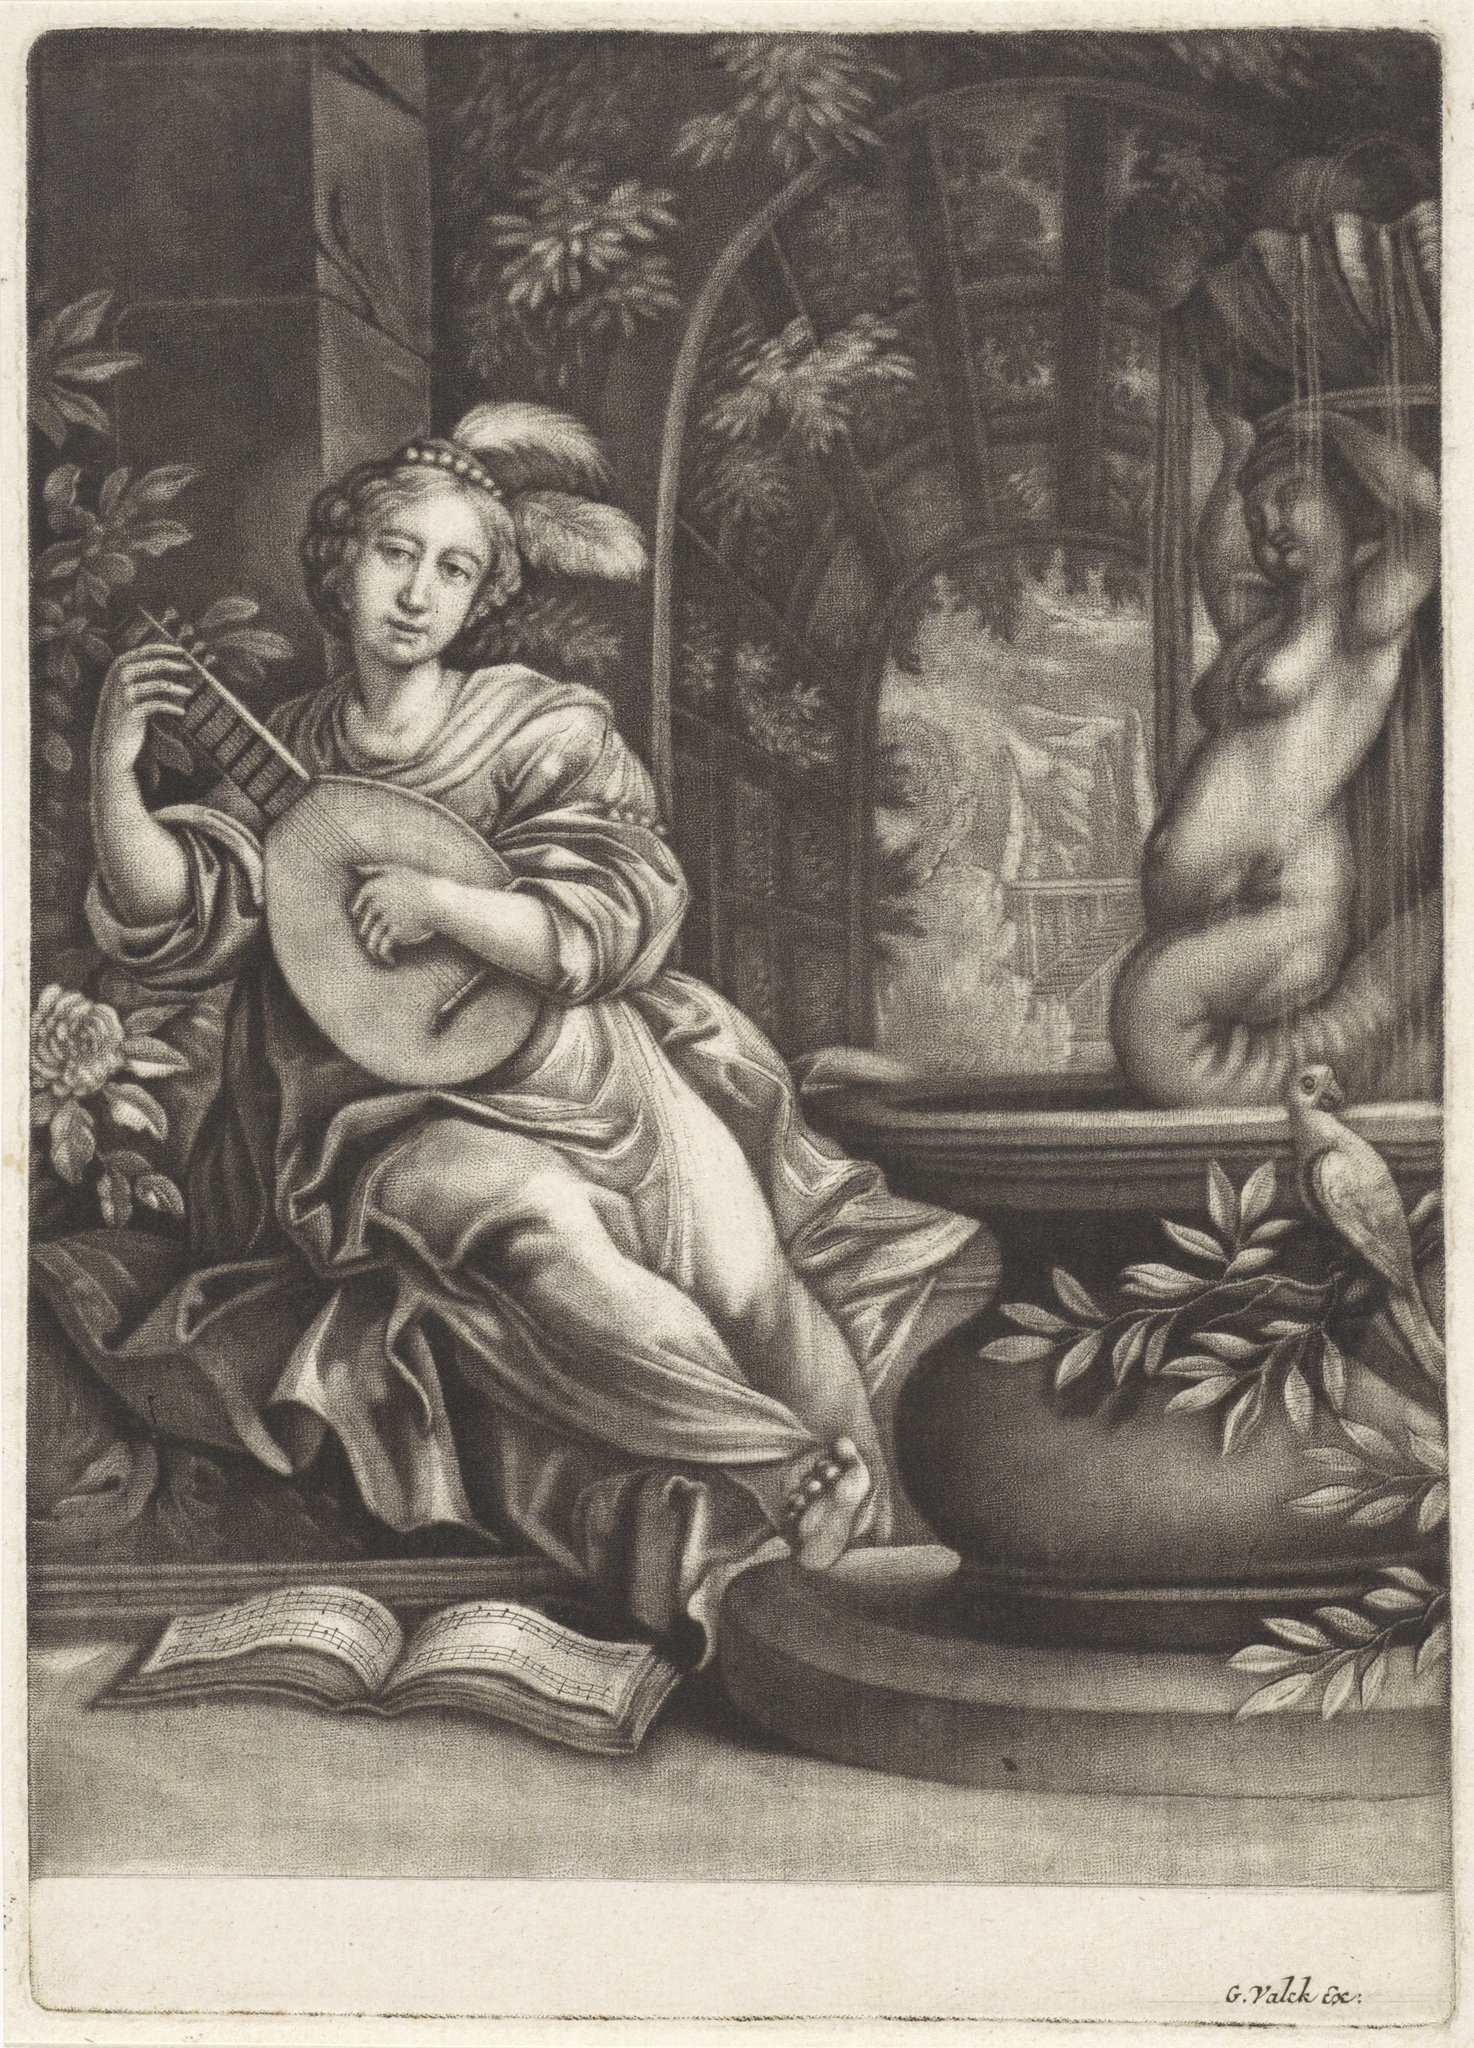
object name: print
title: Luitspeelster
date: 1662-1726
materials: paper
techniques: mezzotint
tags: one person playing string instrument (plucked), lute, and special forms of lute, e.g.: theorbo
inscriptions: collector's mark: Lugt 2228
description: In een tuin zit een jonge vrouw luit te spelen naast een fontein. Voor haar ligt een opengeslagen muziekboek op de grond.